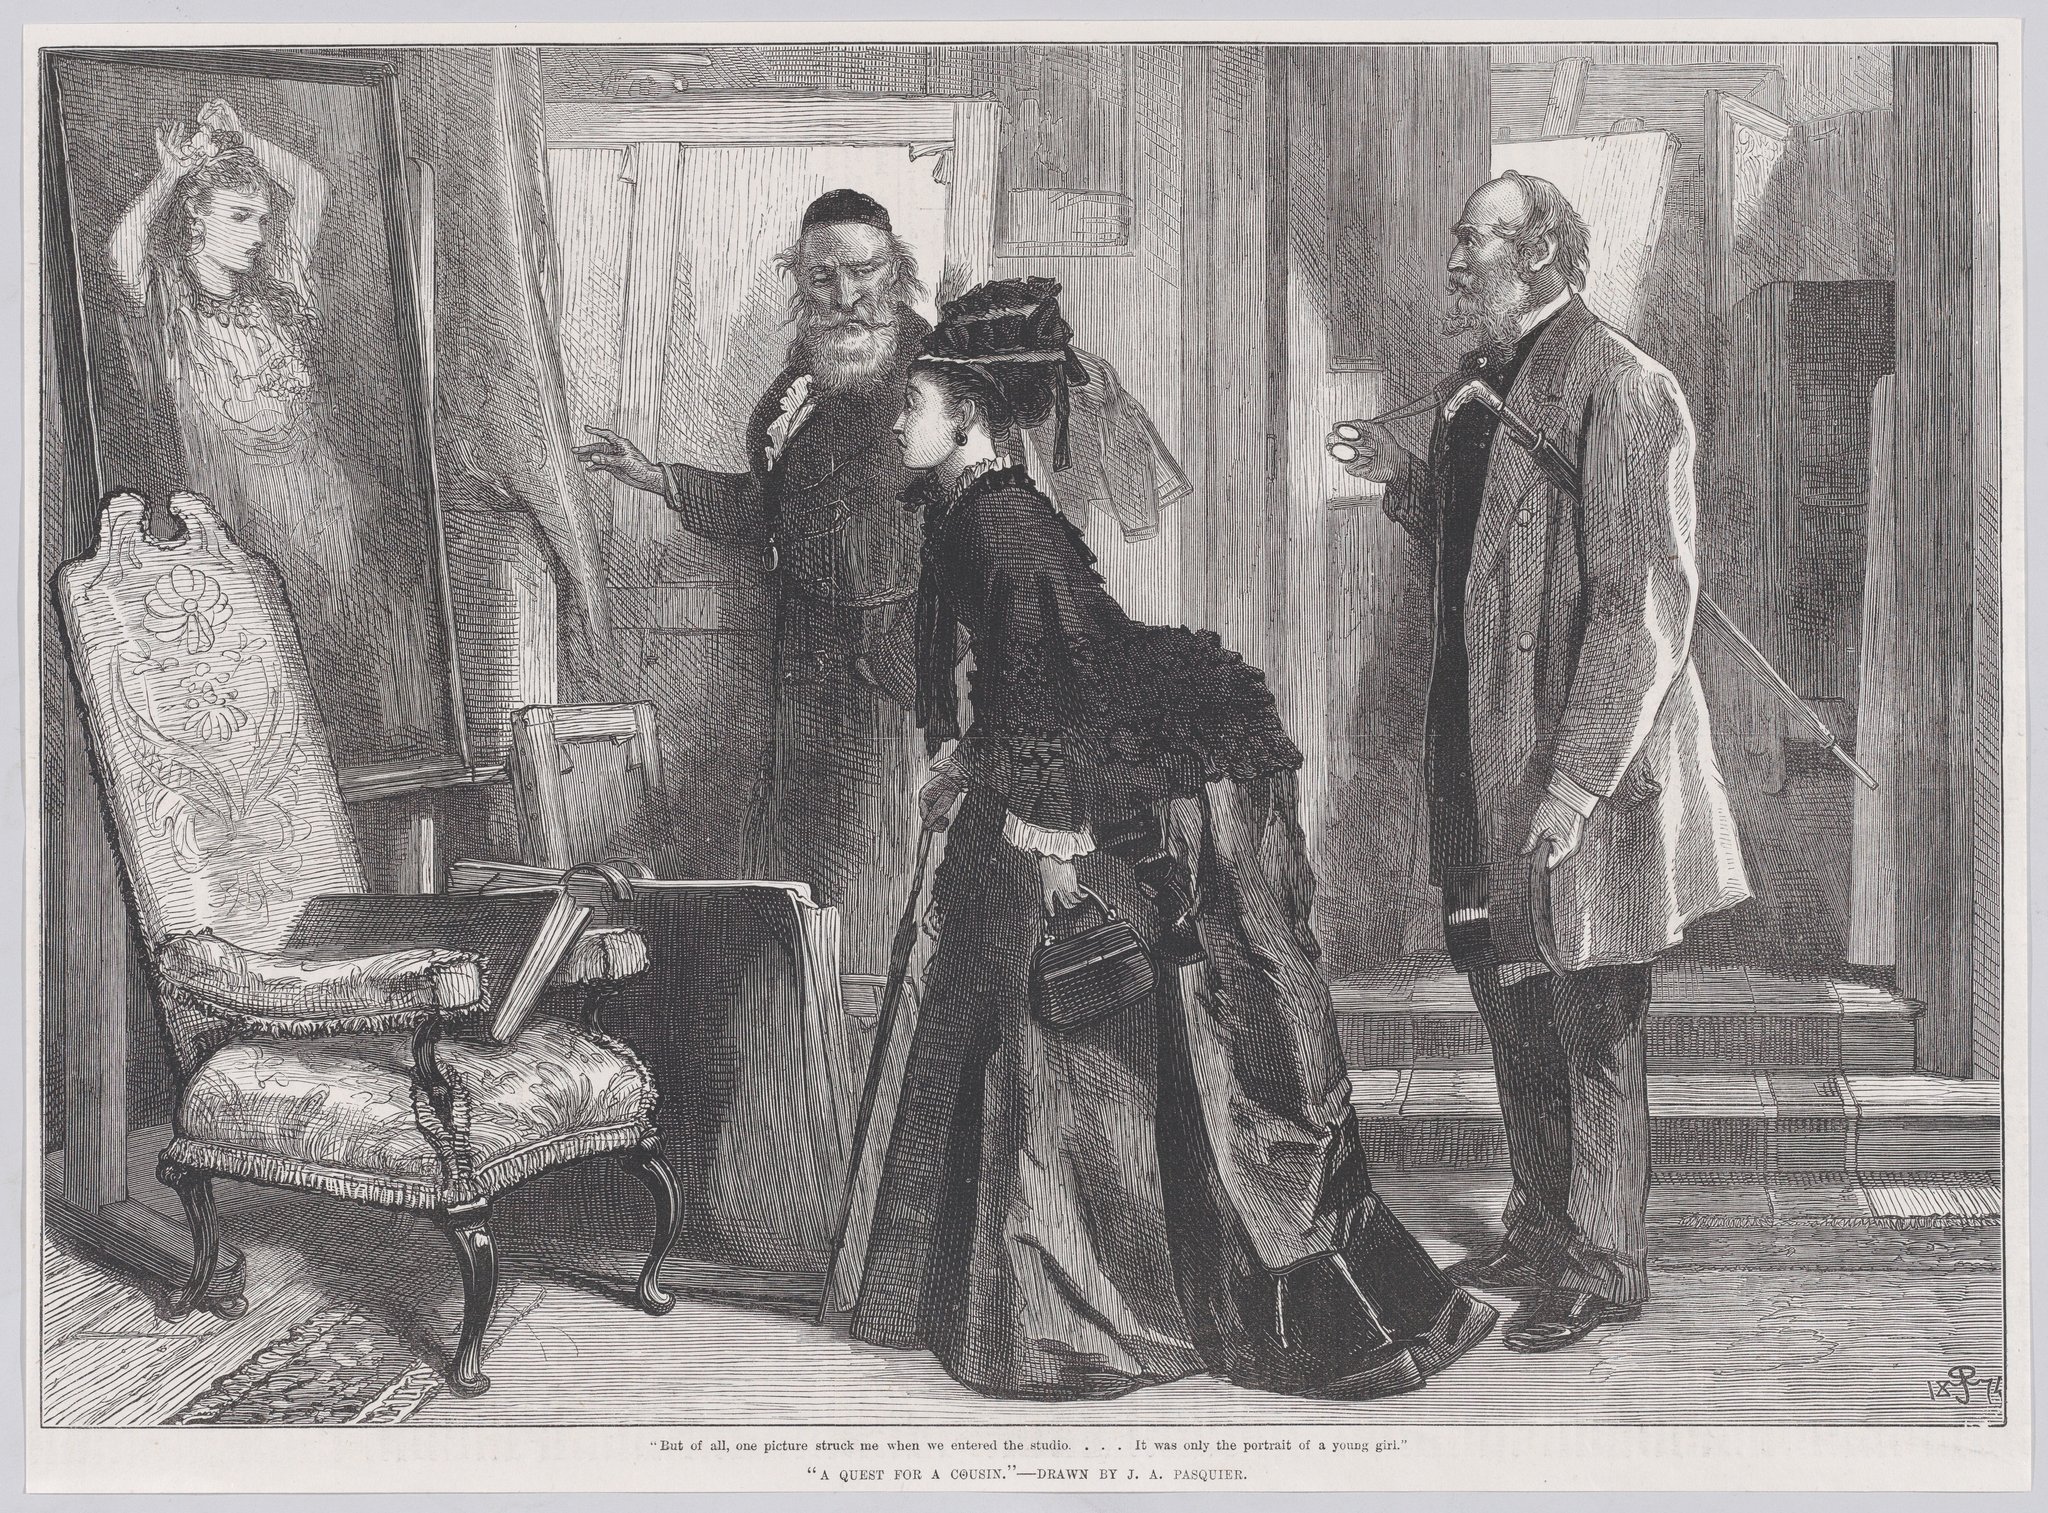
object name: print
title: A Quest for a Cousin, from "Illustrated London News"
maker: james abbott pasquier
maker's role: artist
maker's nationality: british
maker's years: 1827-1879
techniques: engraving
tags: painting,men,women